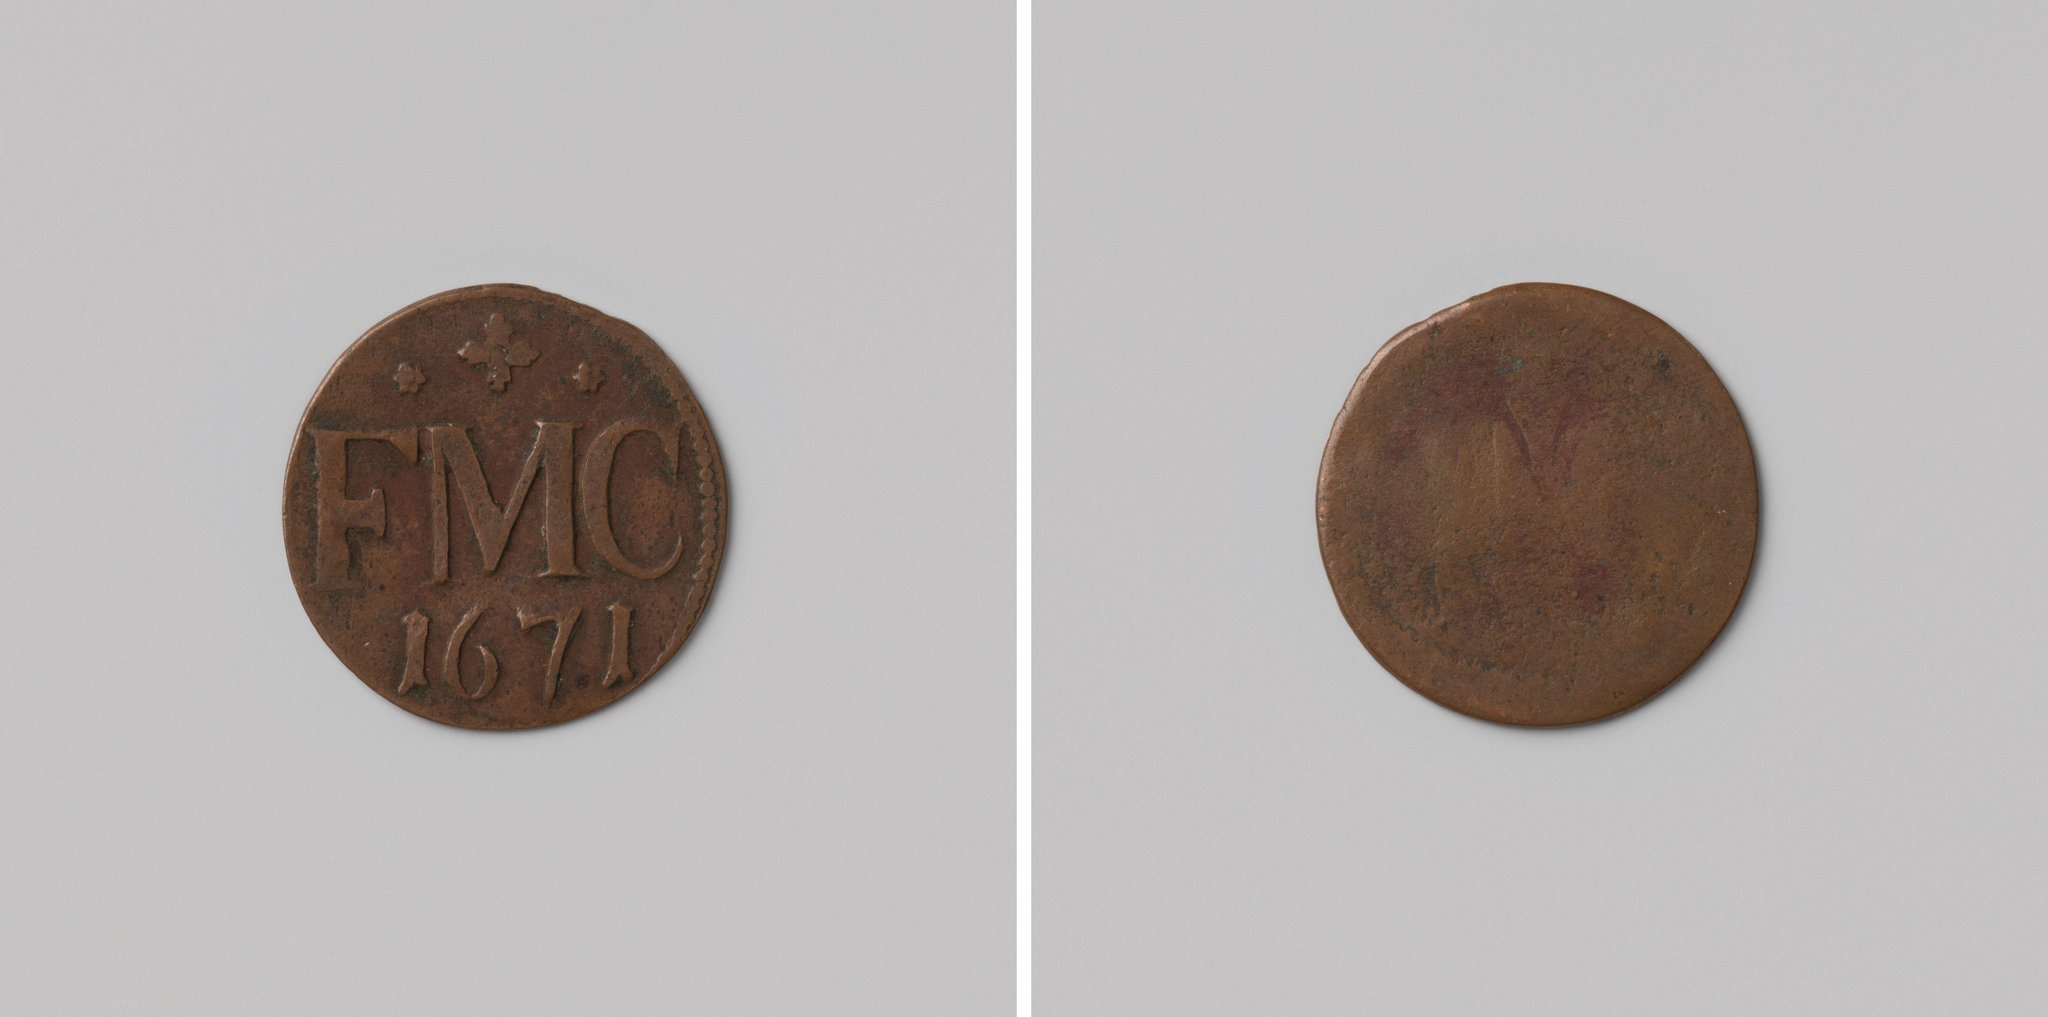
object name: medal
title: Penning met opschrift FMC 1671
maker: Anonymous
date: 1671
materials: copper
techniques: striking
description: Eenzijdige koperen penning. Voorzijde: letters FMC boven jaartal; daarboven: ster tussen twee rozetten. Keerzijde: blanco